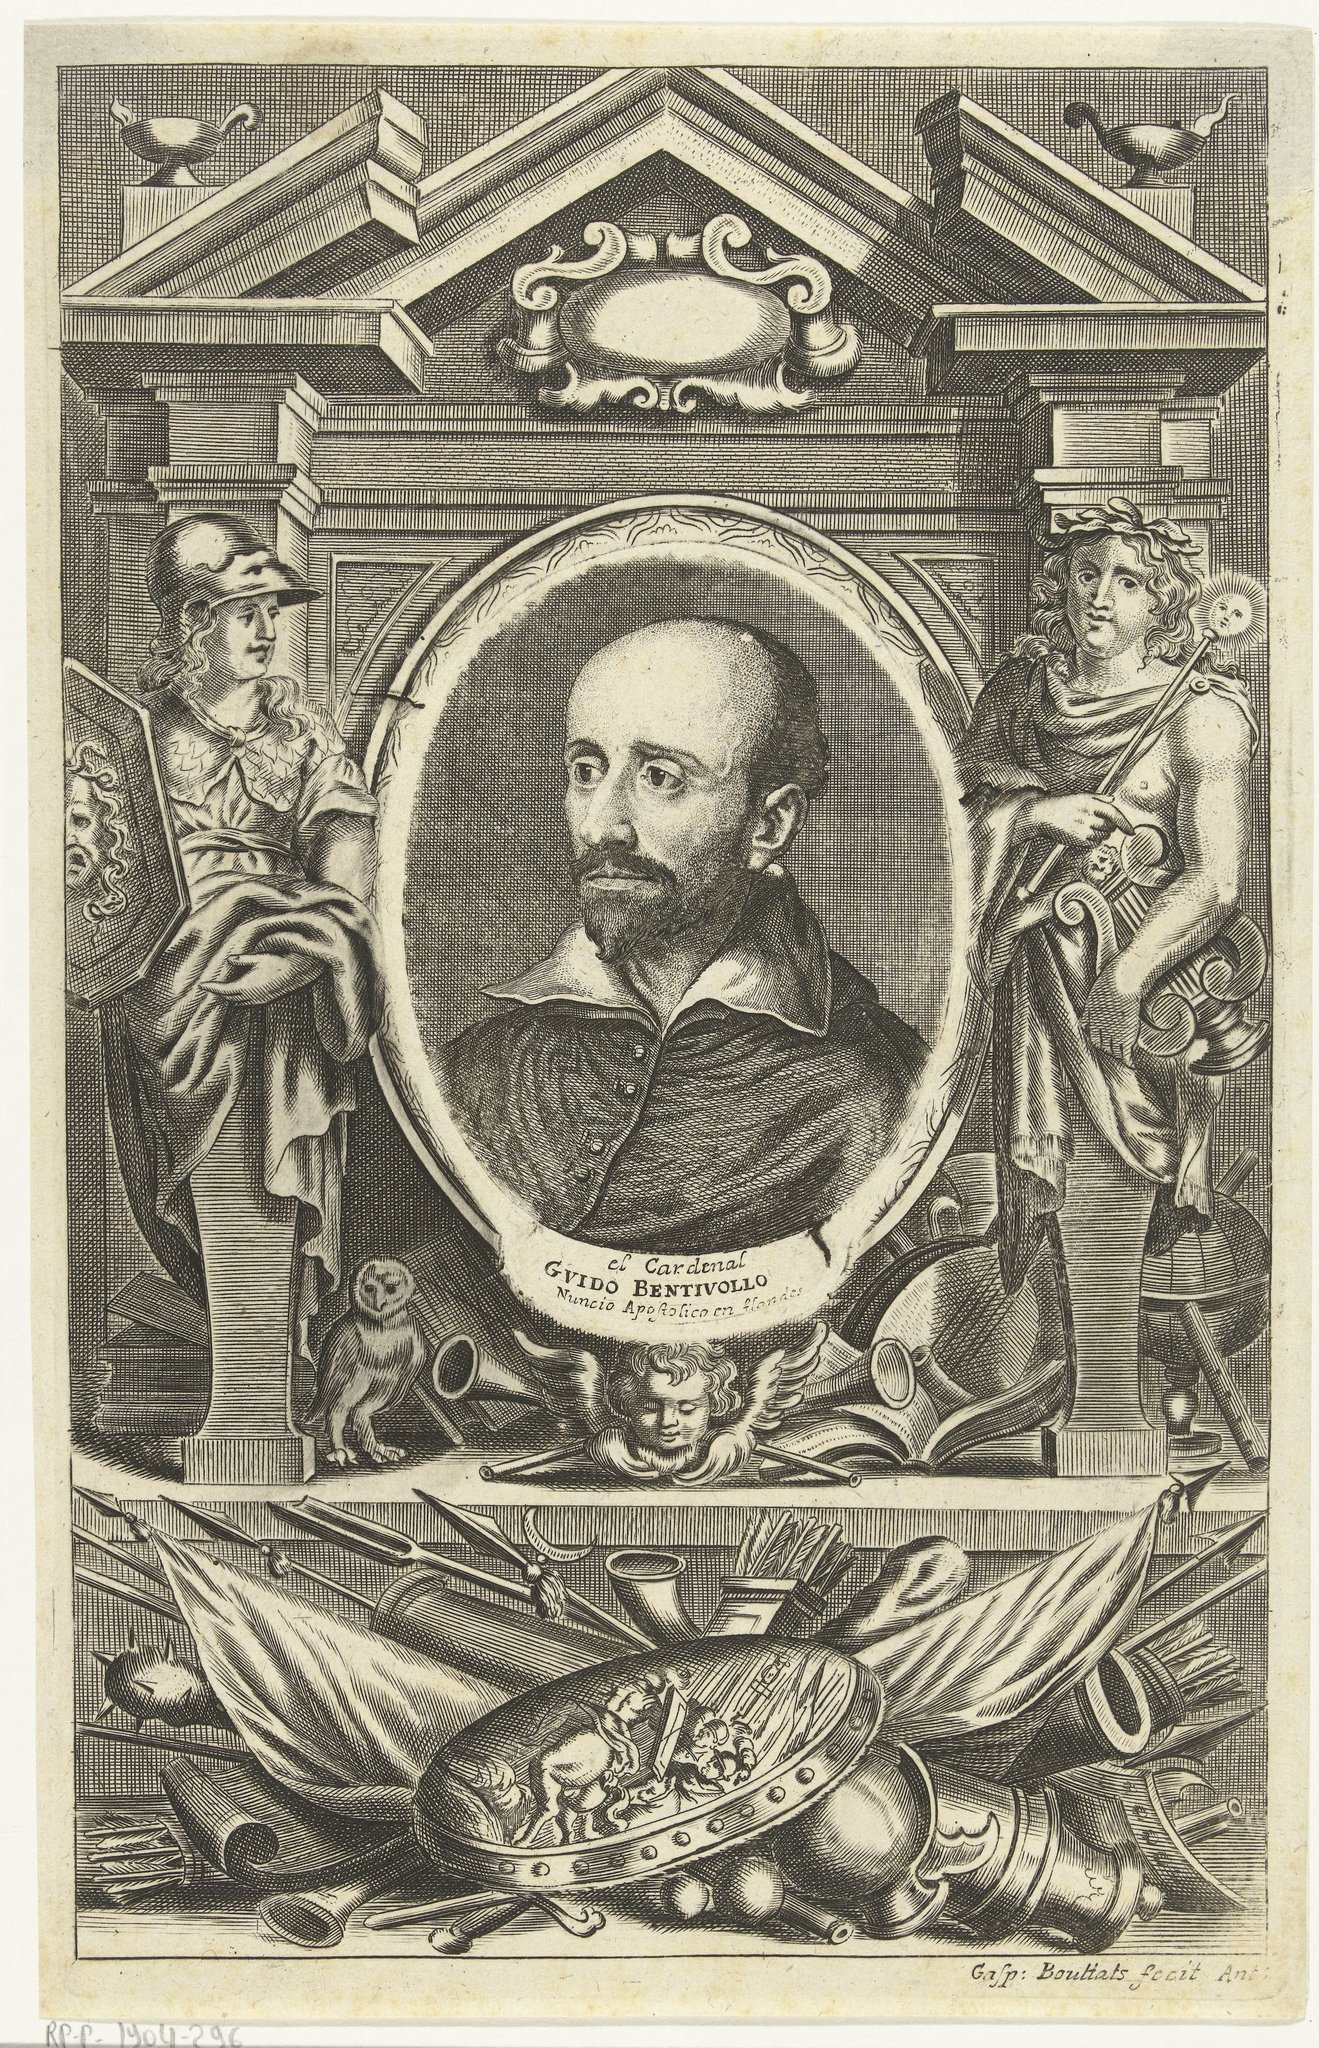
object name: print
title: Portret van kardinaal Guido Bentivoglio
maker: gaspar bouttats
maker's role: print maker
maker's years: 1640-1695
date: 1650-1695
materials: paper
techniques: engraving, etching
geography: antwerp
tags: rome, (story of) apollo (phoebus), (story of) minerva (pallas, athena), the liberal arts represented otherwise, e.g. by emblems, symbols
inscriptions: collector's mark: Lugt 2228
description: Portret in ovale lijst van kardinaal Guido Bentivoglio, kardinaal en apostolische nuntius in de Zuidelijke Nederlanden. Buste naar links.Onder het portret de werktuigen van de zeven vrije kunsten samen met een uiltje. Daaronder allerlei wapens en een schild met een afbeelding van een slagveld.